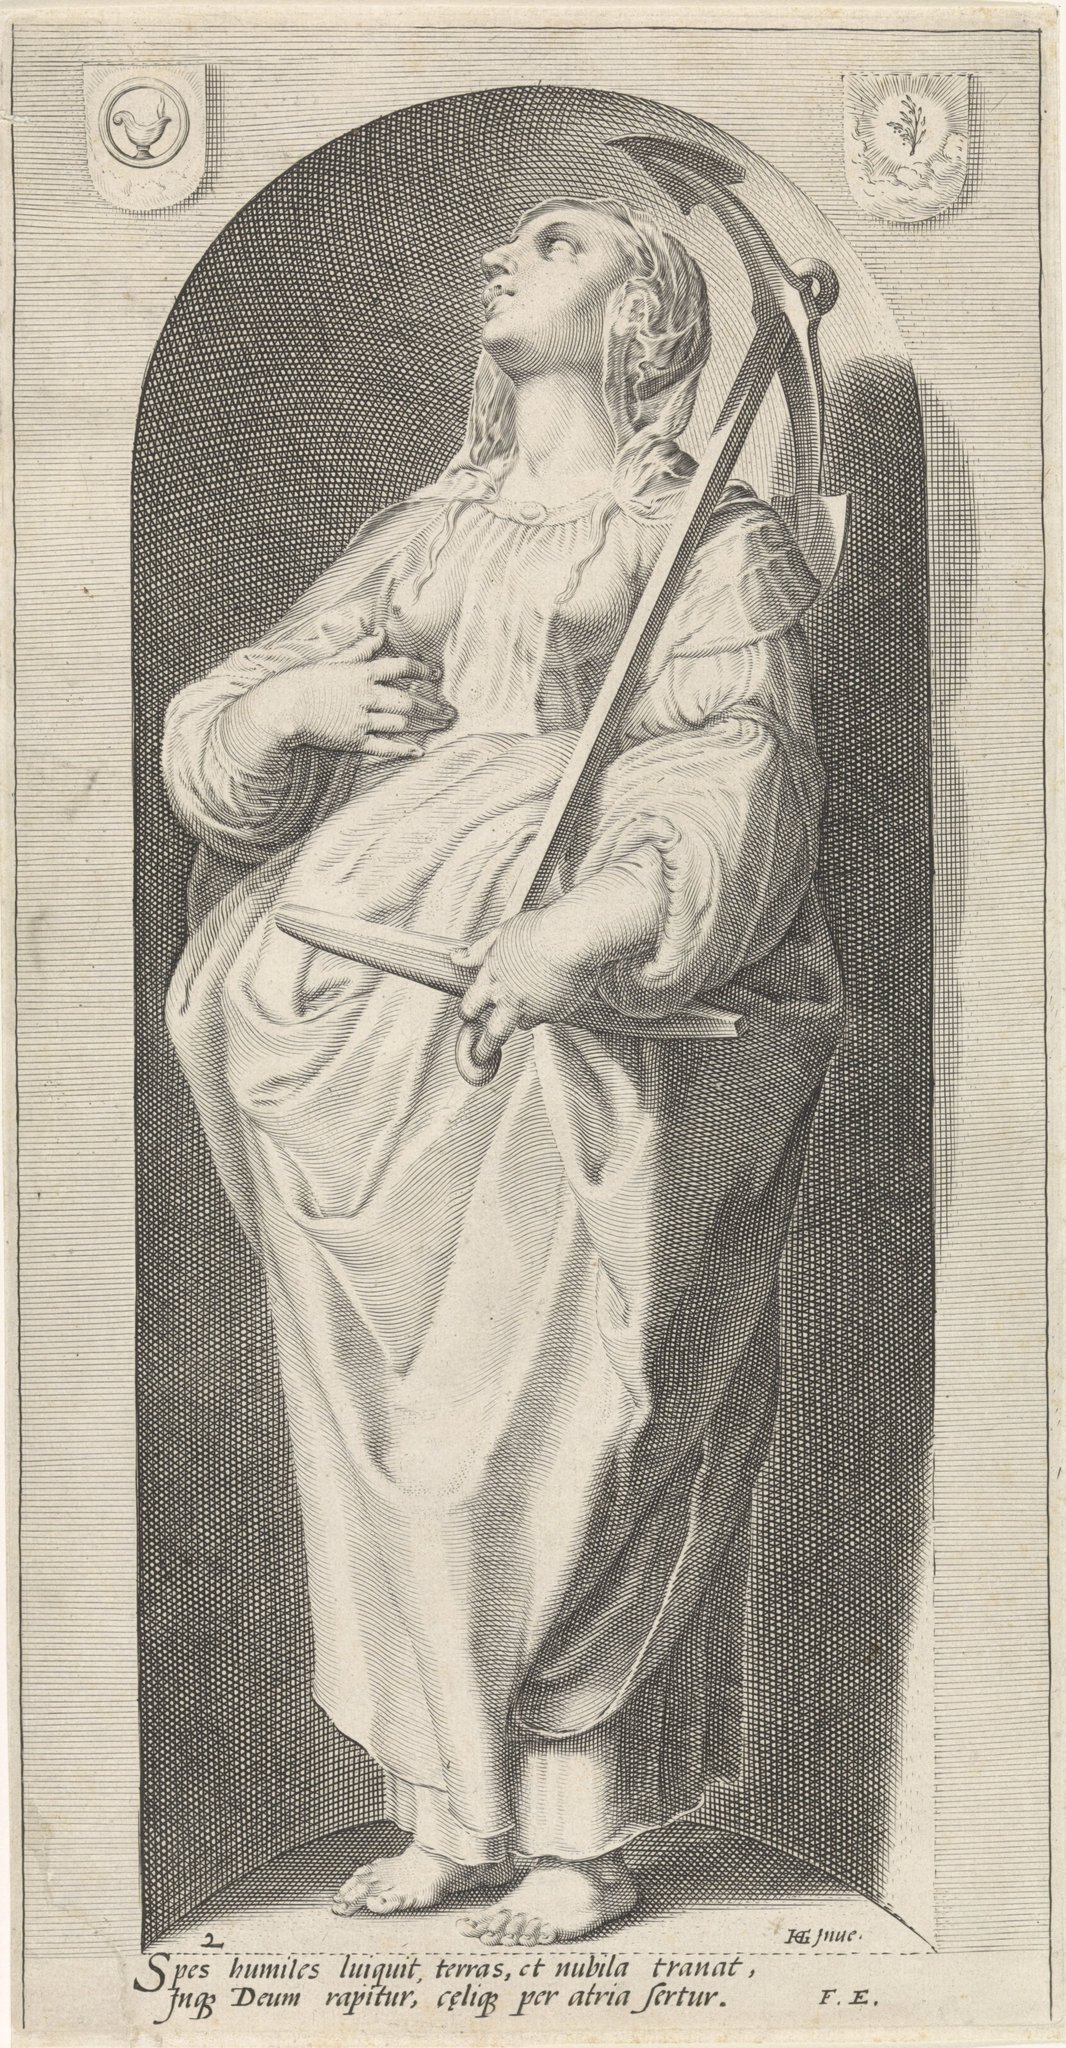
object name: print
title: Hoop (Spes)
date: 1593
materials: paper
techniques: engraving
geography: haarlem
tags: hope, 'spes'; 'speranza divina e certa' (ripa) ~ one of the three theological virtues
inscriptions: collector's mark: Lugt 2228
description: Personificatie van de hoop, met anker, staand in nis.